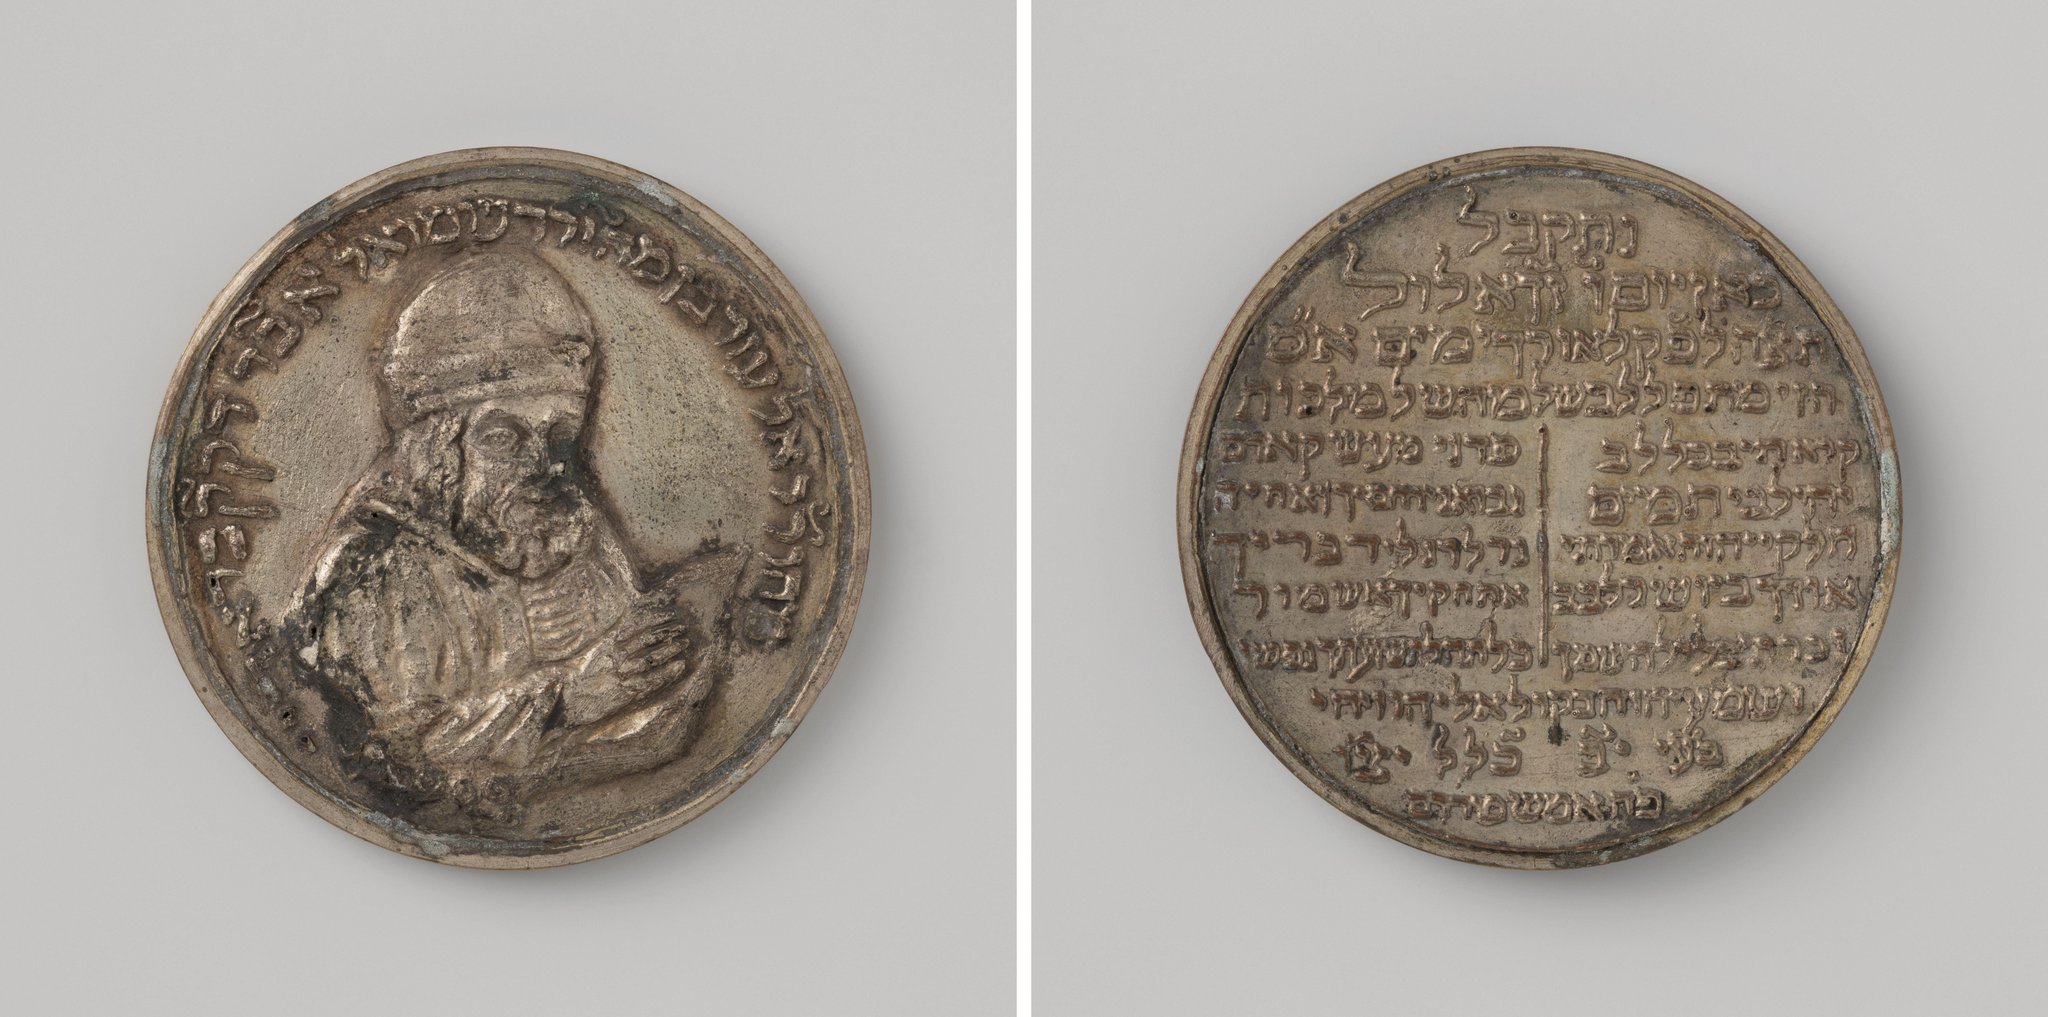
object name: history medal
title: Eleazar van Brody, opperrabijn van Amsterdam 1735-1740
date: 1735-1740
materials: copper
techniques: galvanoplasty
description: Galvanoplastische reproductie van voor- en keerzijde van de penning, samen met een rand rond een loden kern, op de voorzijde Eleazar ten halven lijve half naar rechts met boek, met omschrift in Hebreeuwse karakters, op de keerzijde twaalf regels tekst in Hebreeuwse karakters, de middelste regels in twee kolommen.